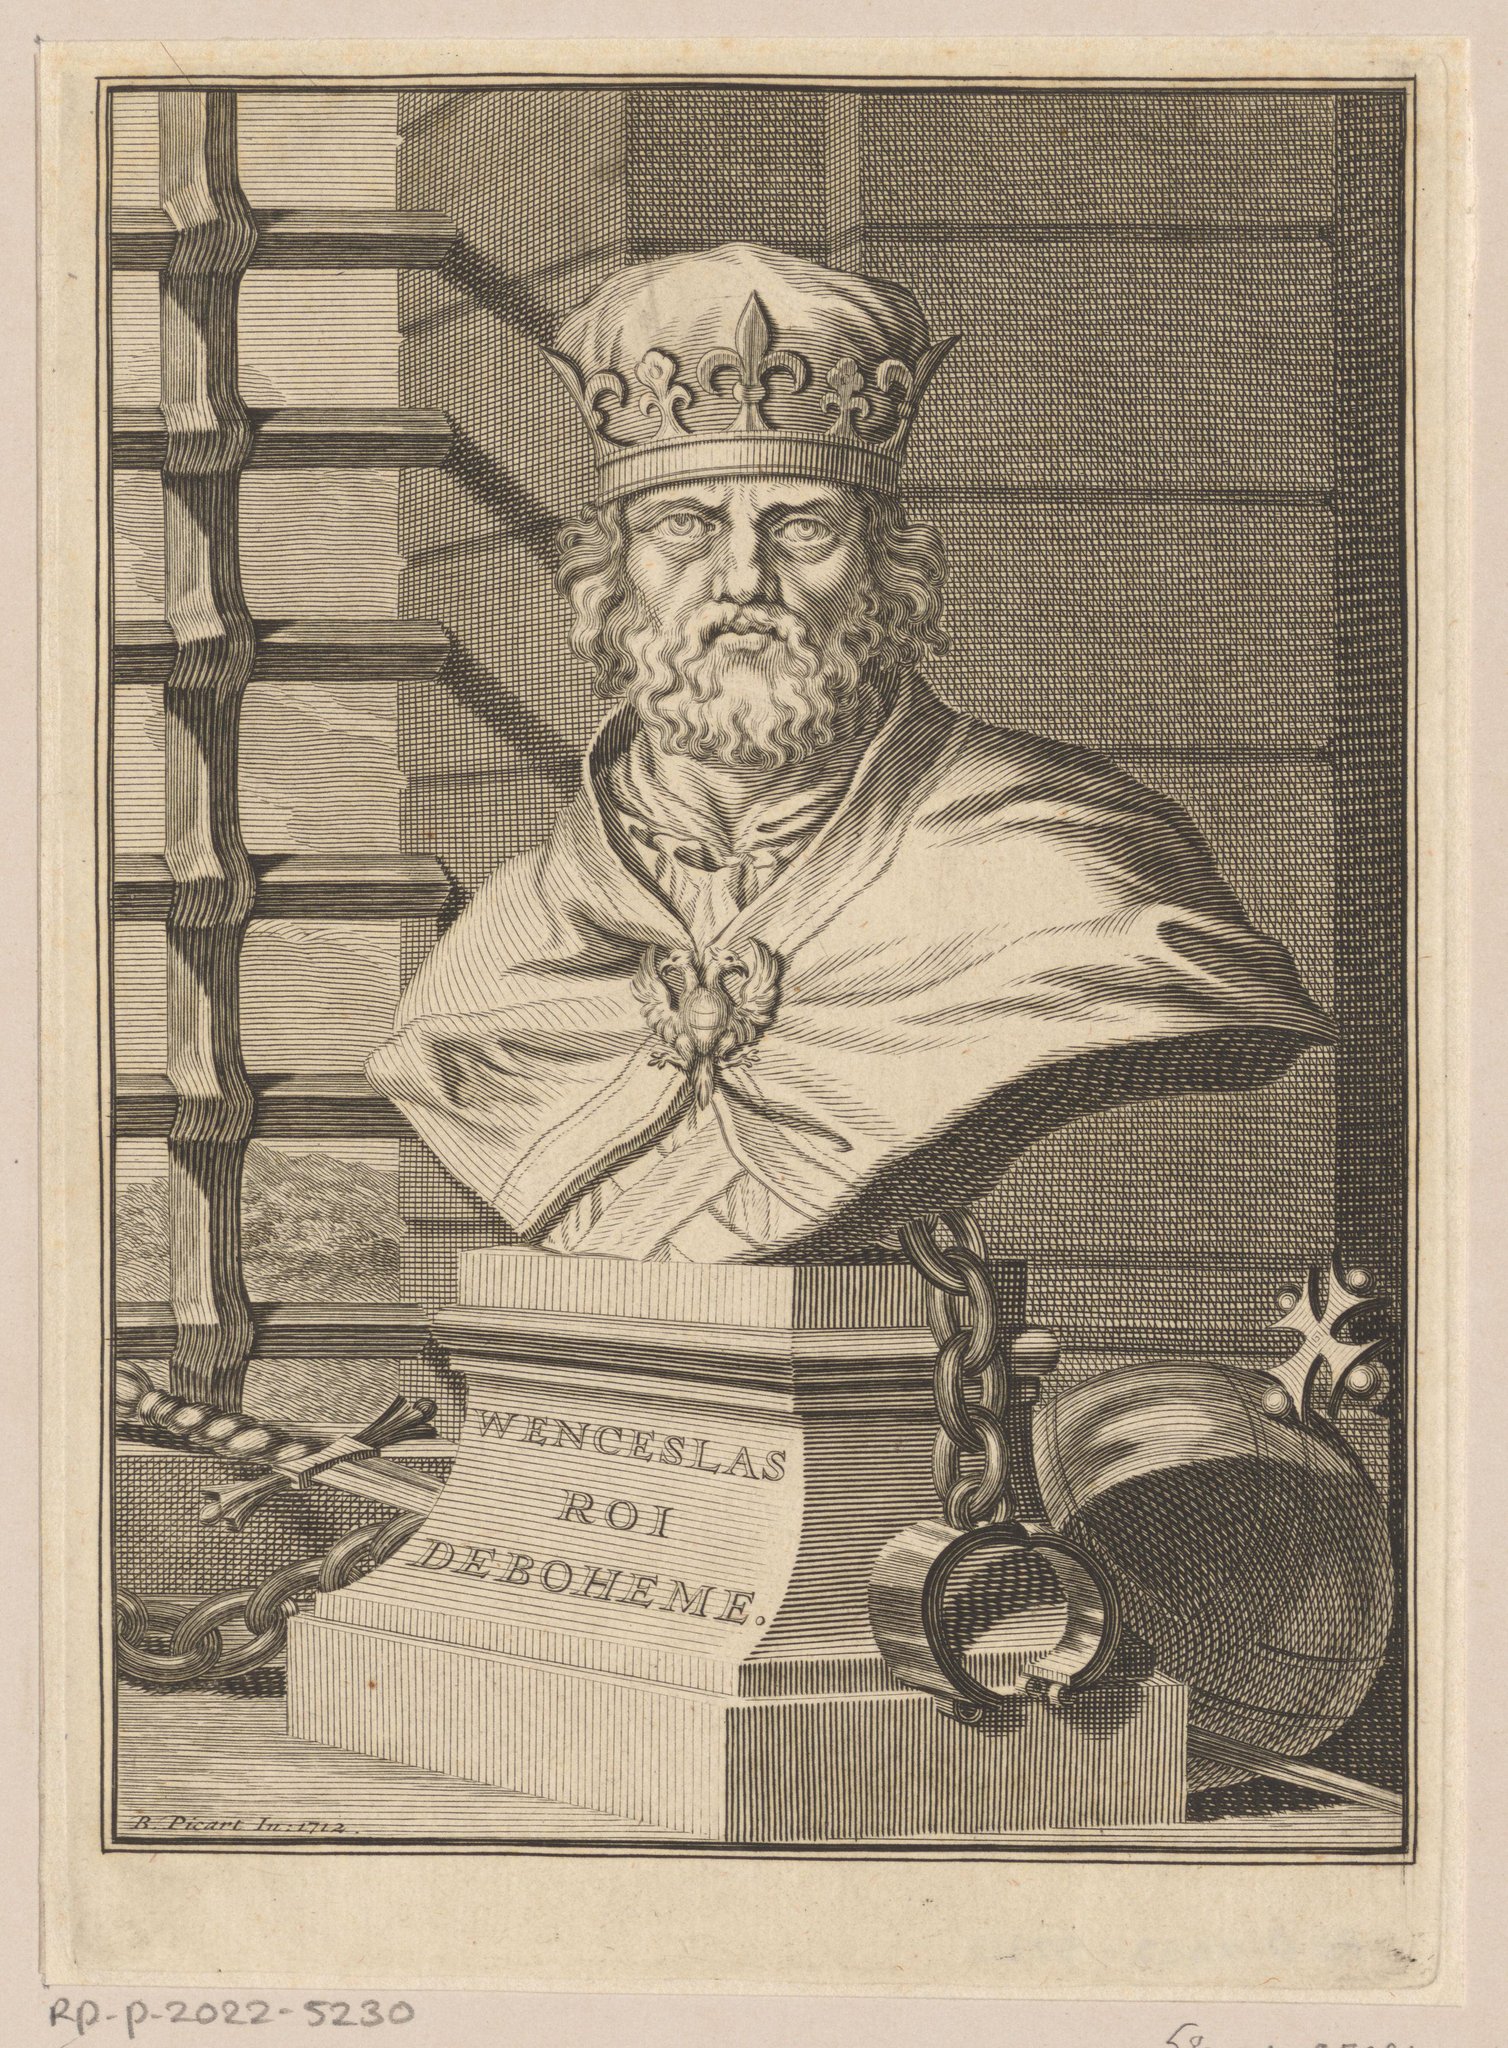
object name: print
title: Buste van Wenceslaus van Bohemen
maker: bernard picart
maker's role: draughtsman, print maker, publisher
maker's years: 1673-1733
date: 1712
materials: paper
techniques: engraving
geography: amsterdam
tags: prague, orb (symbol of sovereignty; sphere with cross on top), knighthood order, historical persons, king